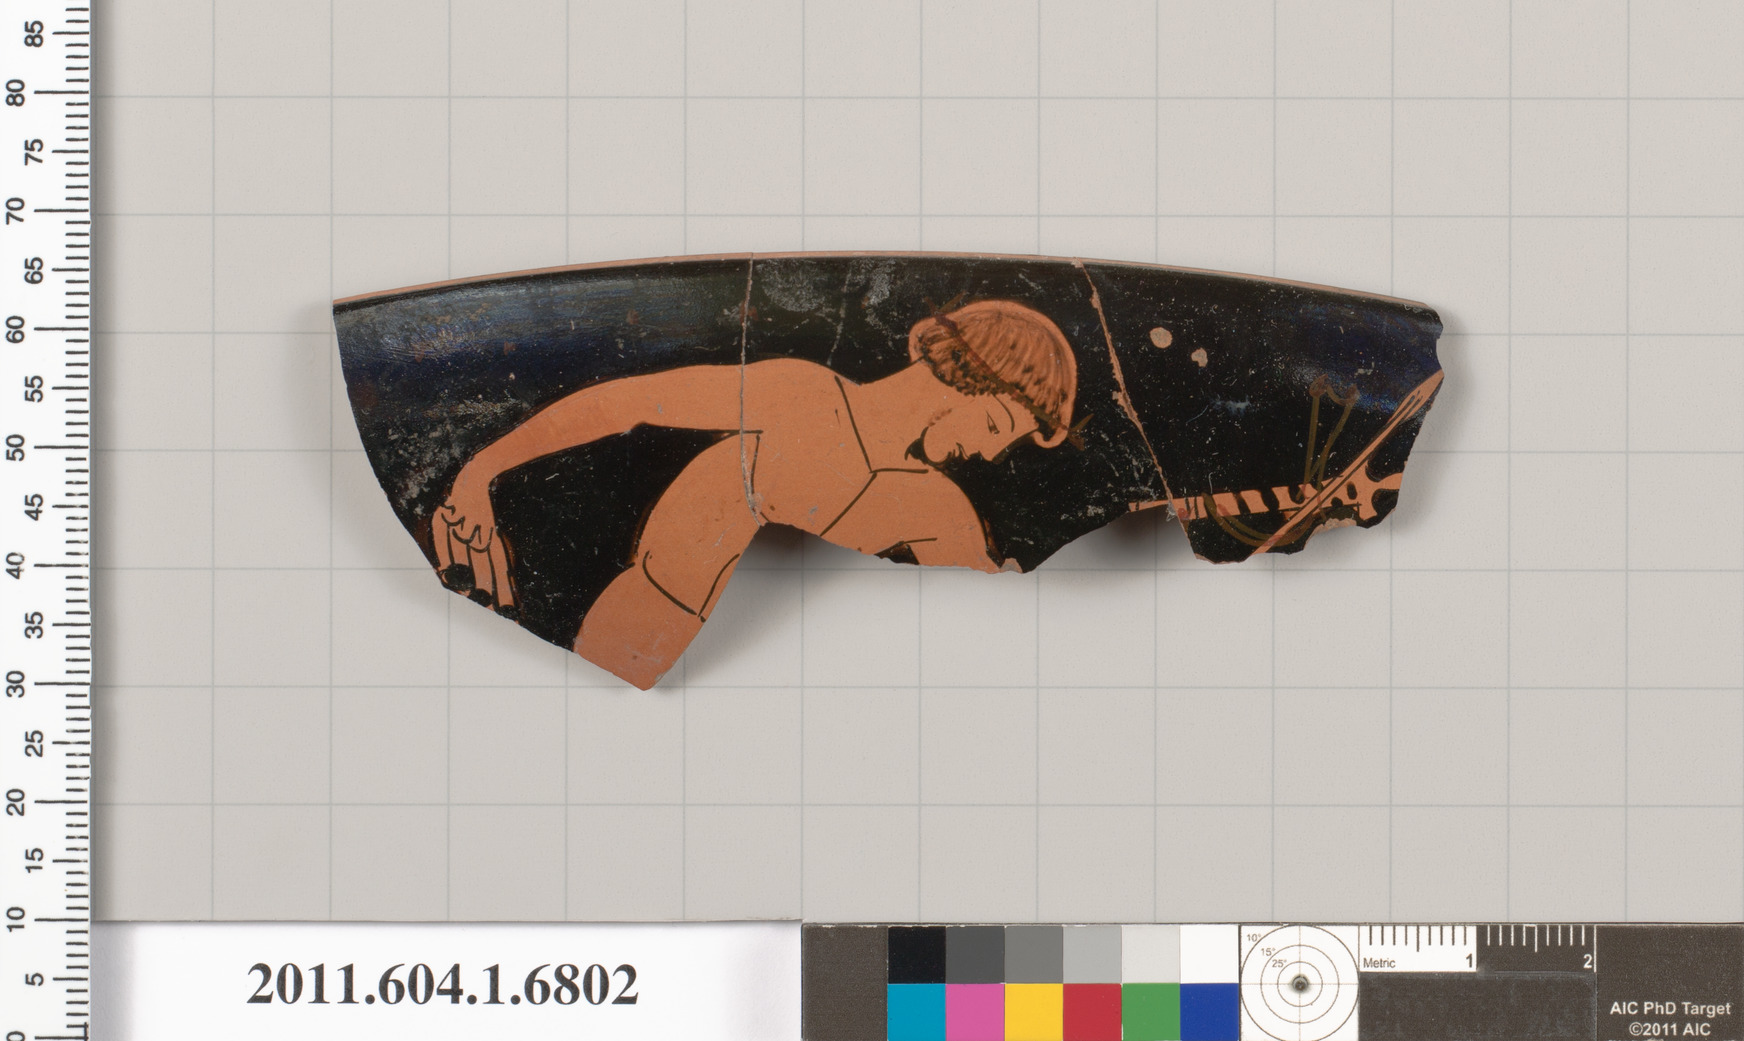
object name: kylix fragment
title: Terracotta rim fragment of a kylix (drinking cup)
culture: greek, attic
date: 490-470 BCE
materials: terracotta